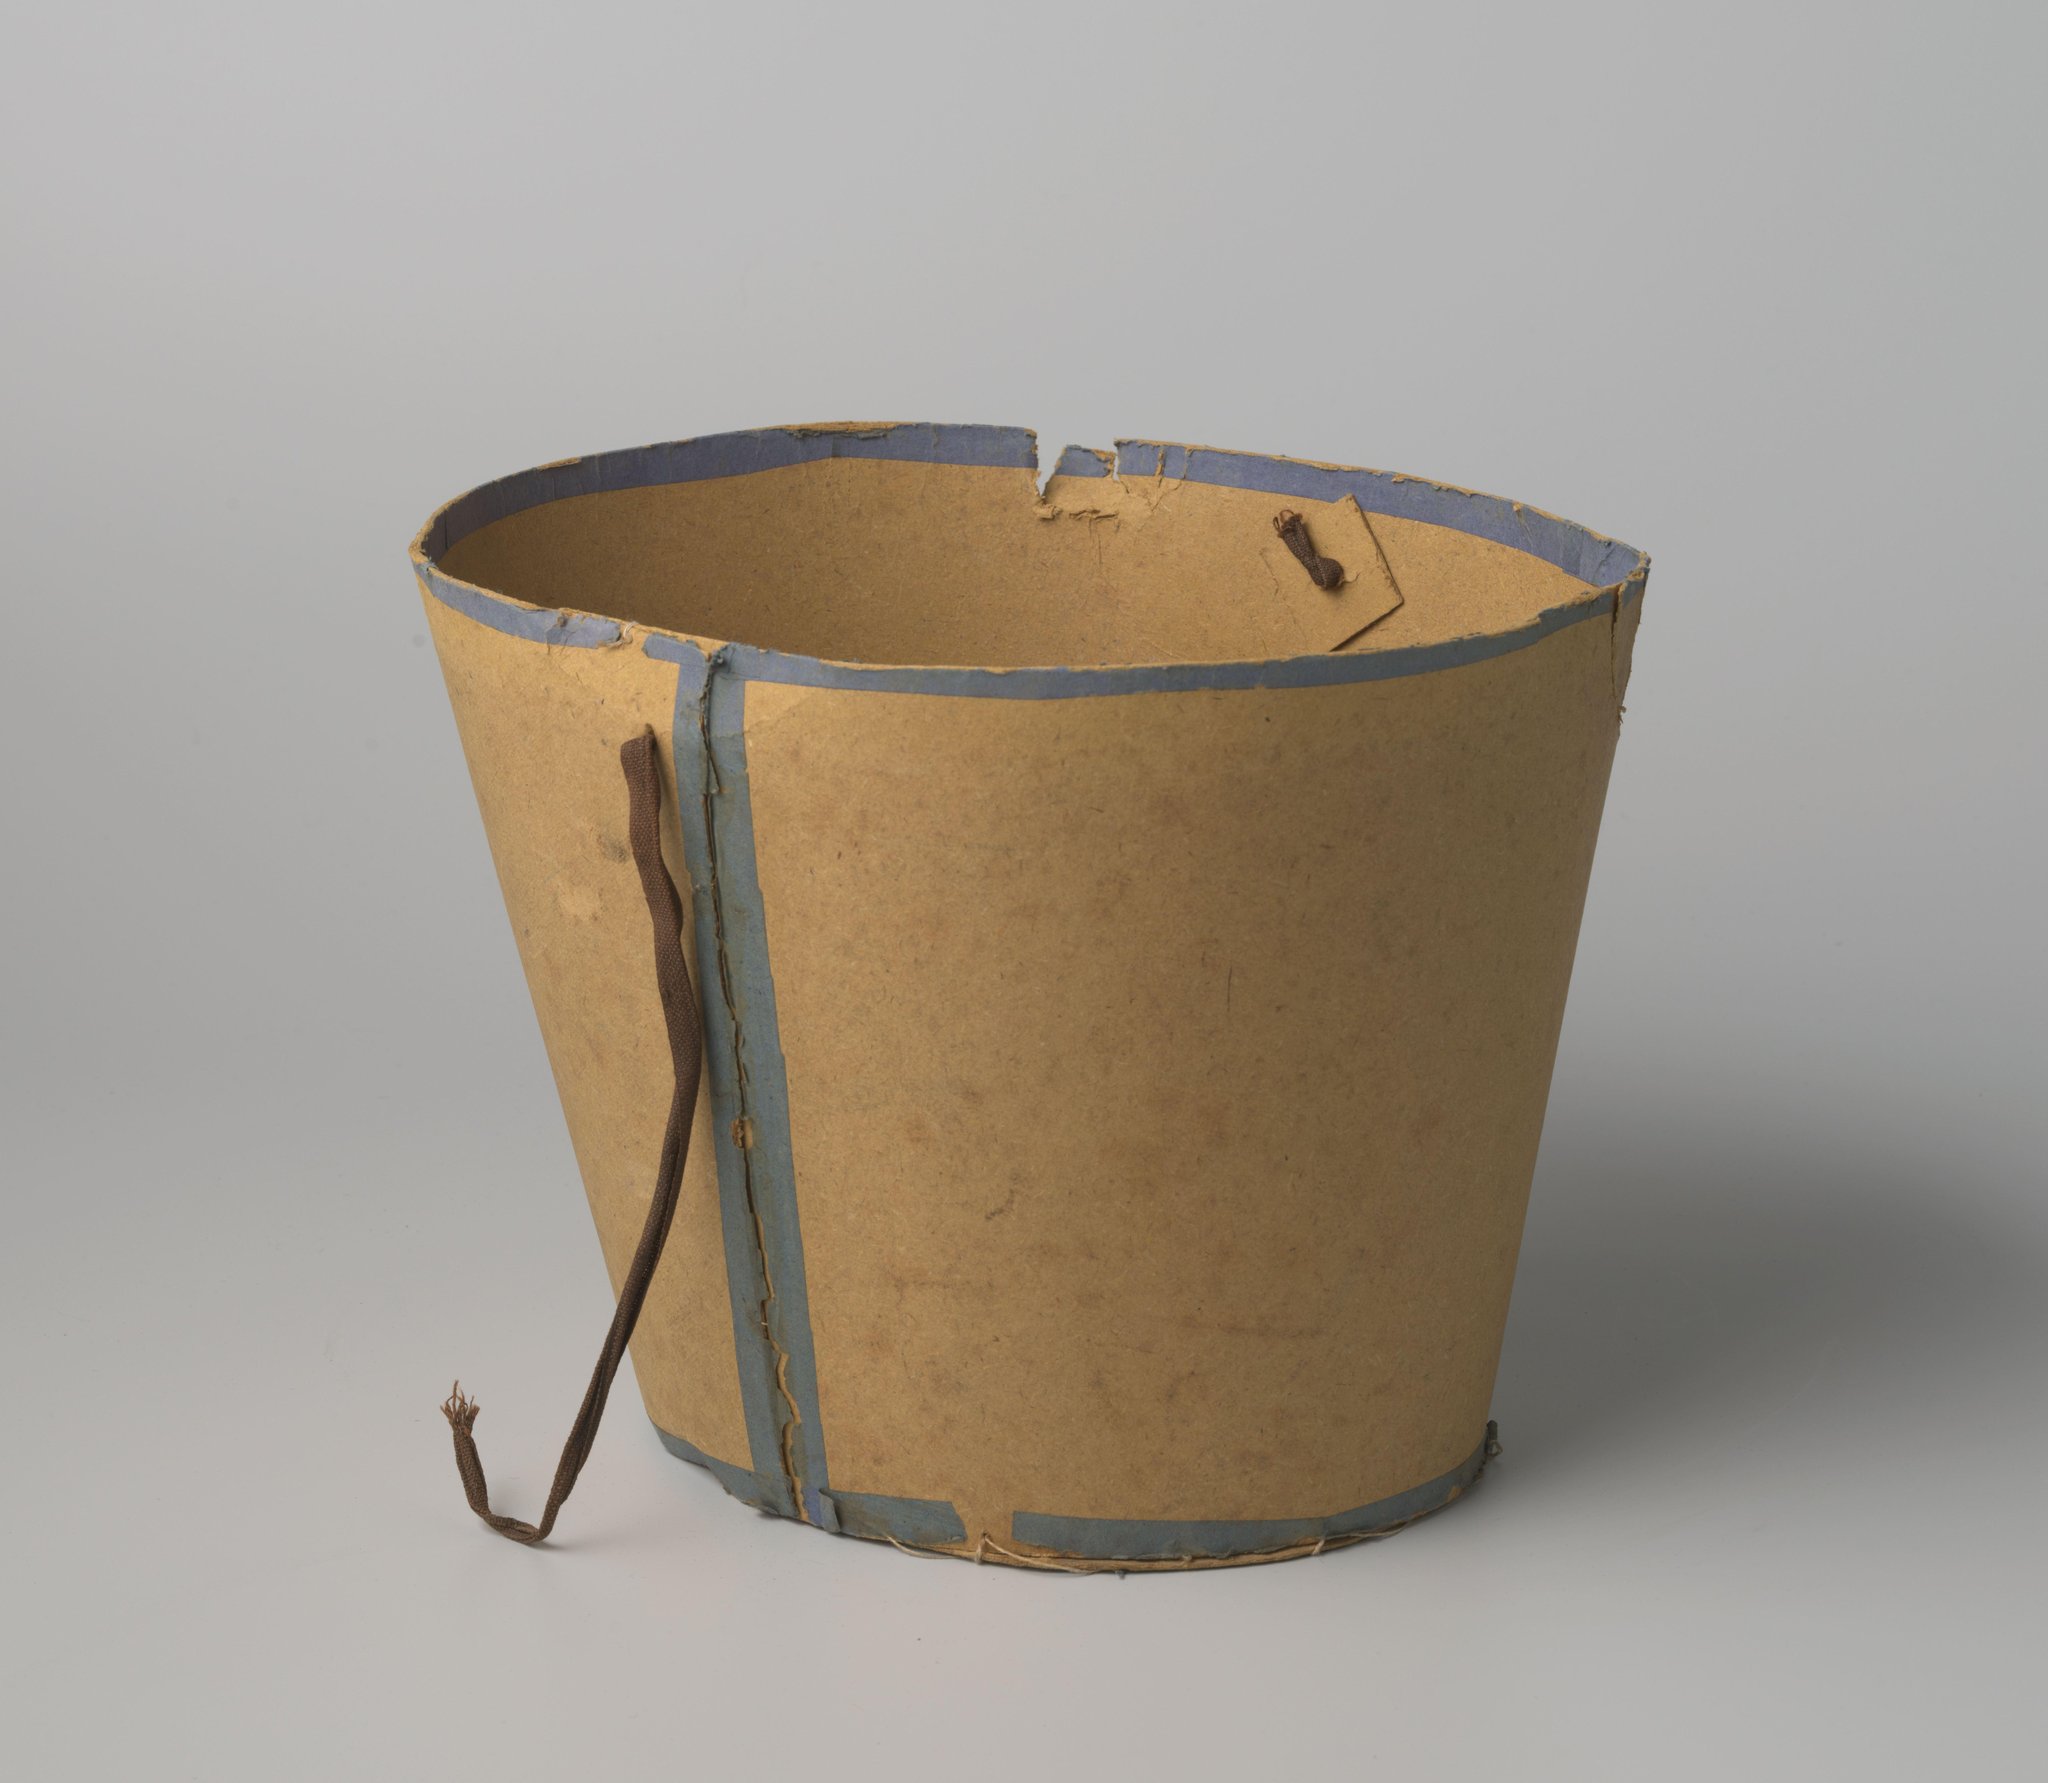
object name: hat box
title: Kegelvormige doos van bruin karton, versierd met blauwe biezen; het deksel ontbreekt; bestemd voor een sjako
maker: Anonymous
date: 1870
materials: cardboard, linen, paper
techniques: pasting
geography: paris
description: Kegelvormige doos van bruin karton, versierd met blauwe biezen; het deksel ontbreekt. Bestemd voor een sjako.